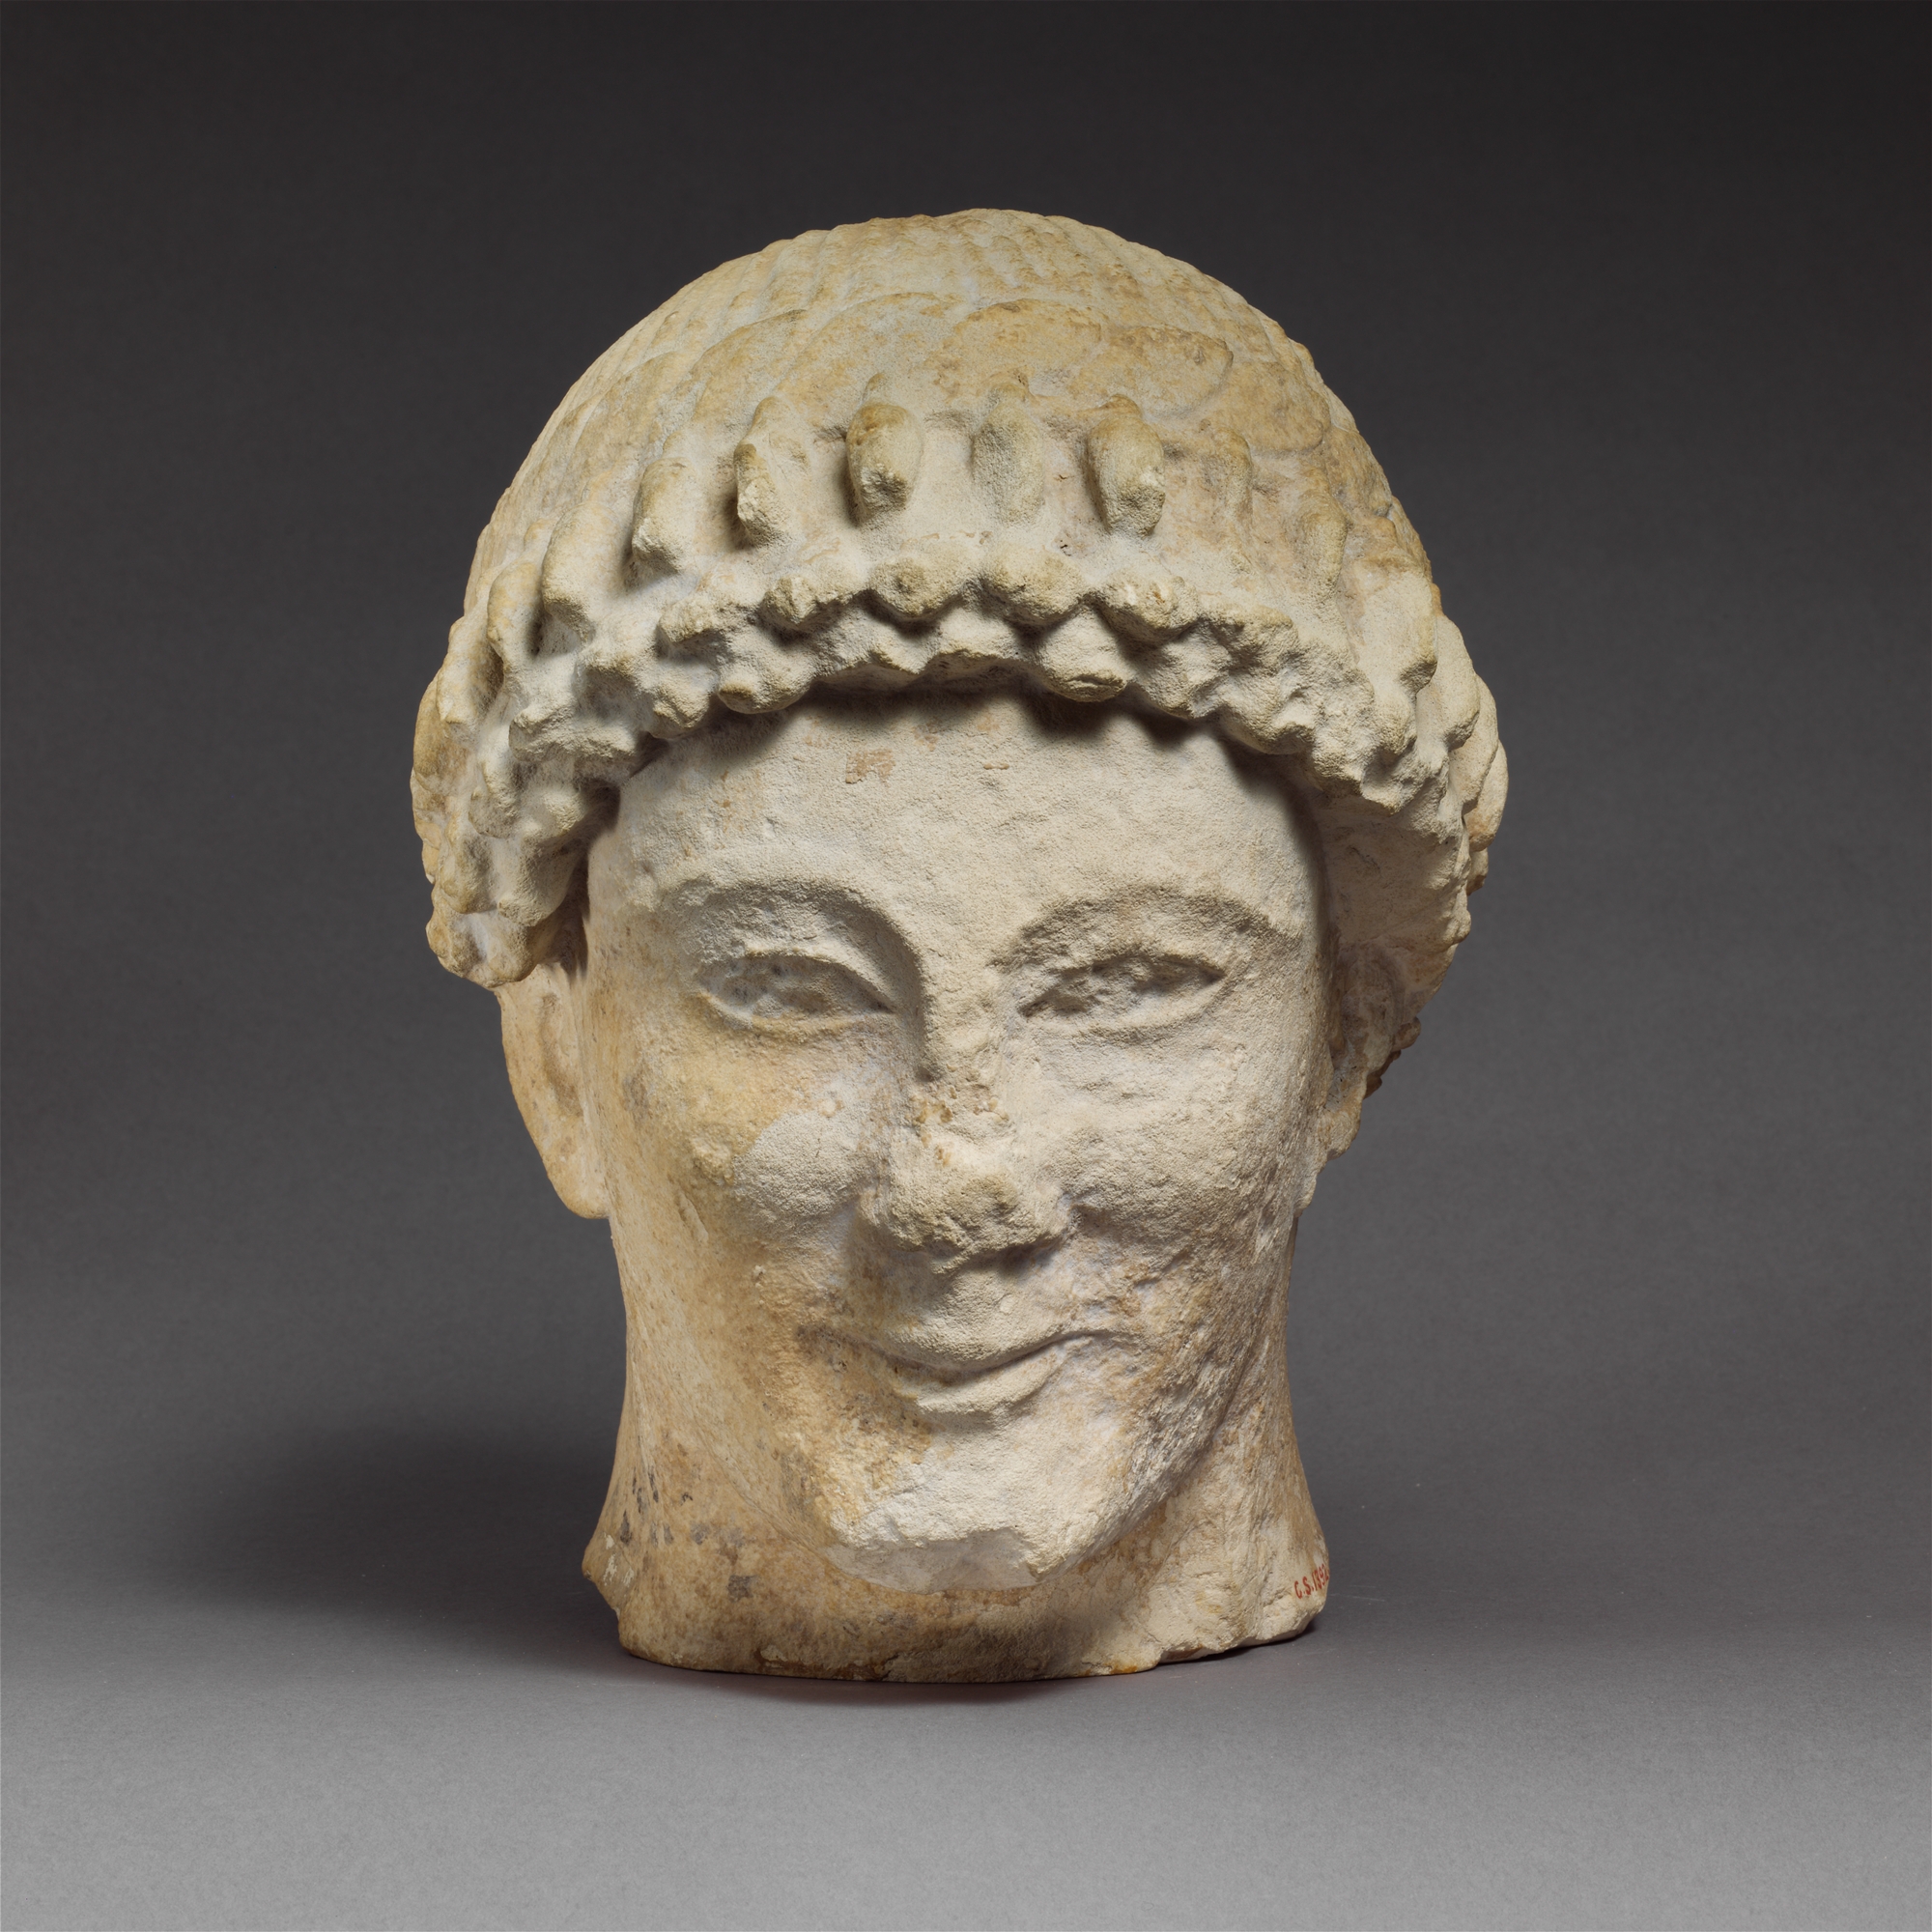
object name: head of a man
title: Limestone head of a beardless male with a wreath of flower buds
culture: cypriot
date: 500-468 BCE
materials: limestone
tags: heads,men,wreaths